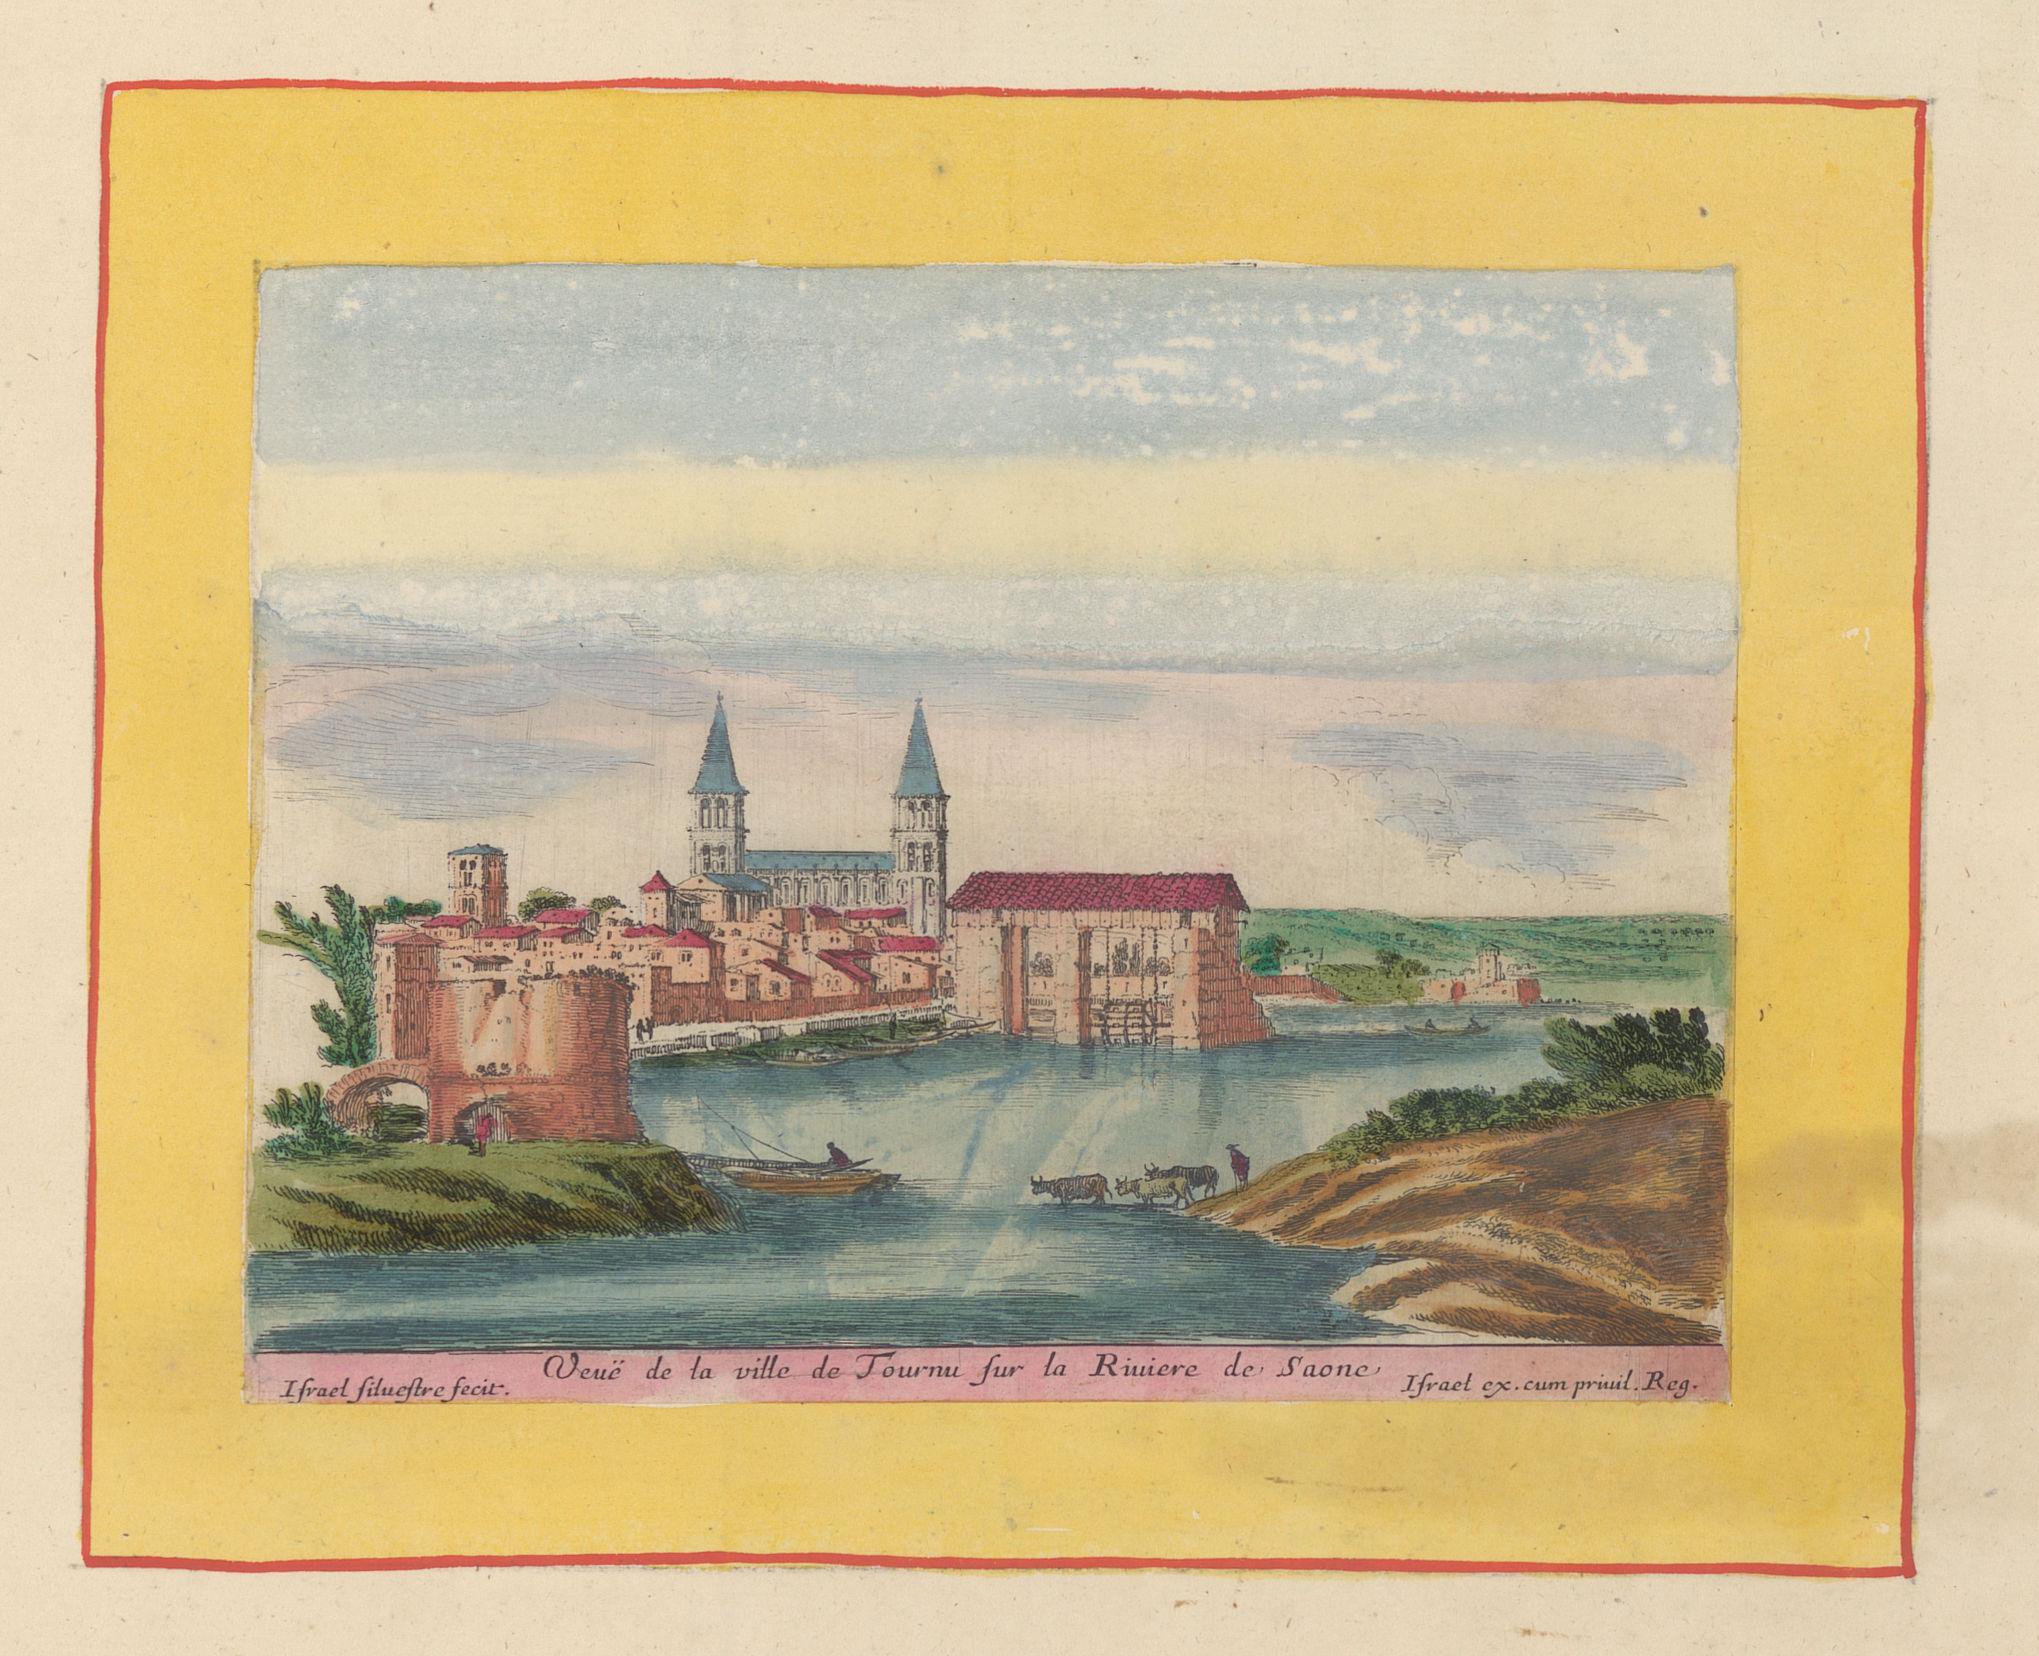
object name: print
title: Gezicht op Tournus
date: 1631-1661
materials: paper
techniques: etching, hand coloring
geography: paris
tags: city-view in general; 'veduta'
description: Deze prent maakt deel uit van een album.